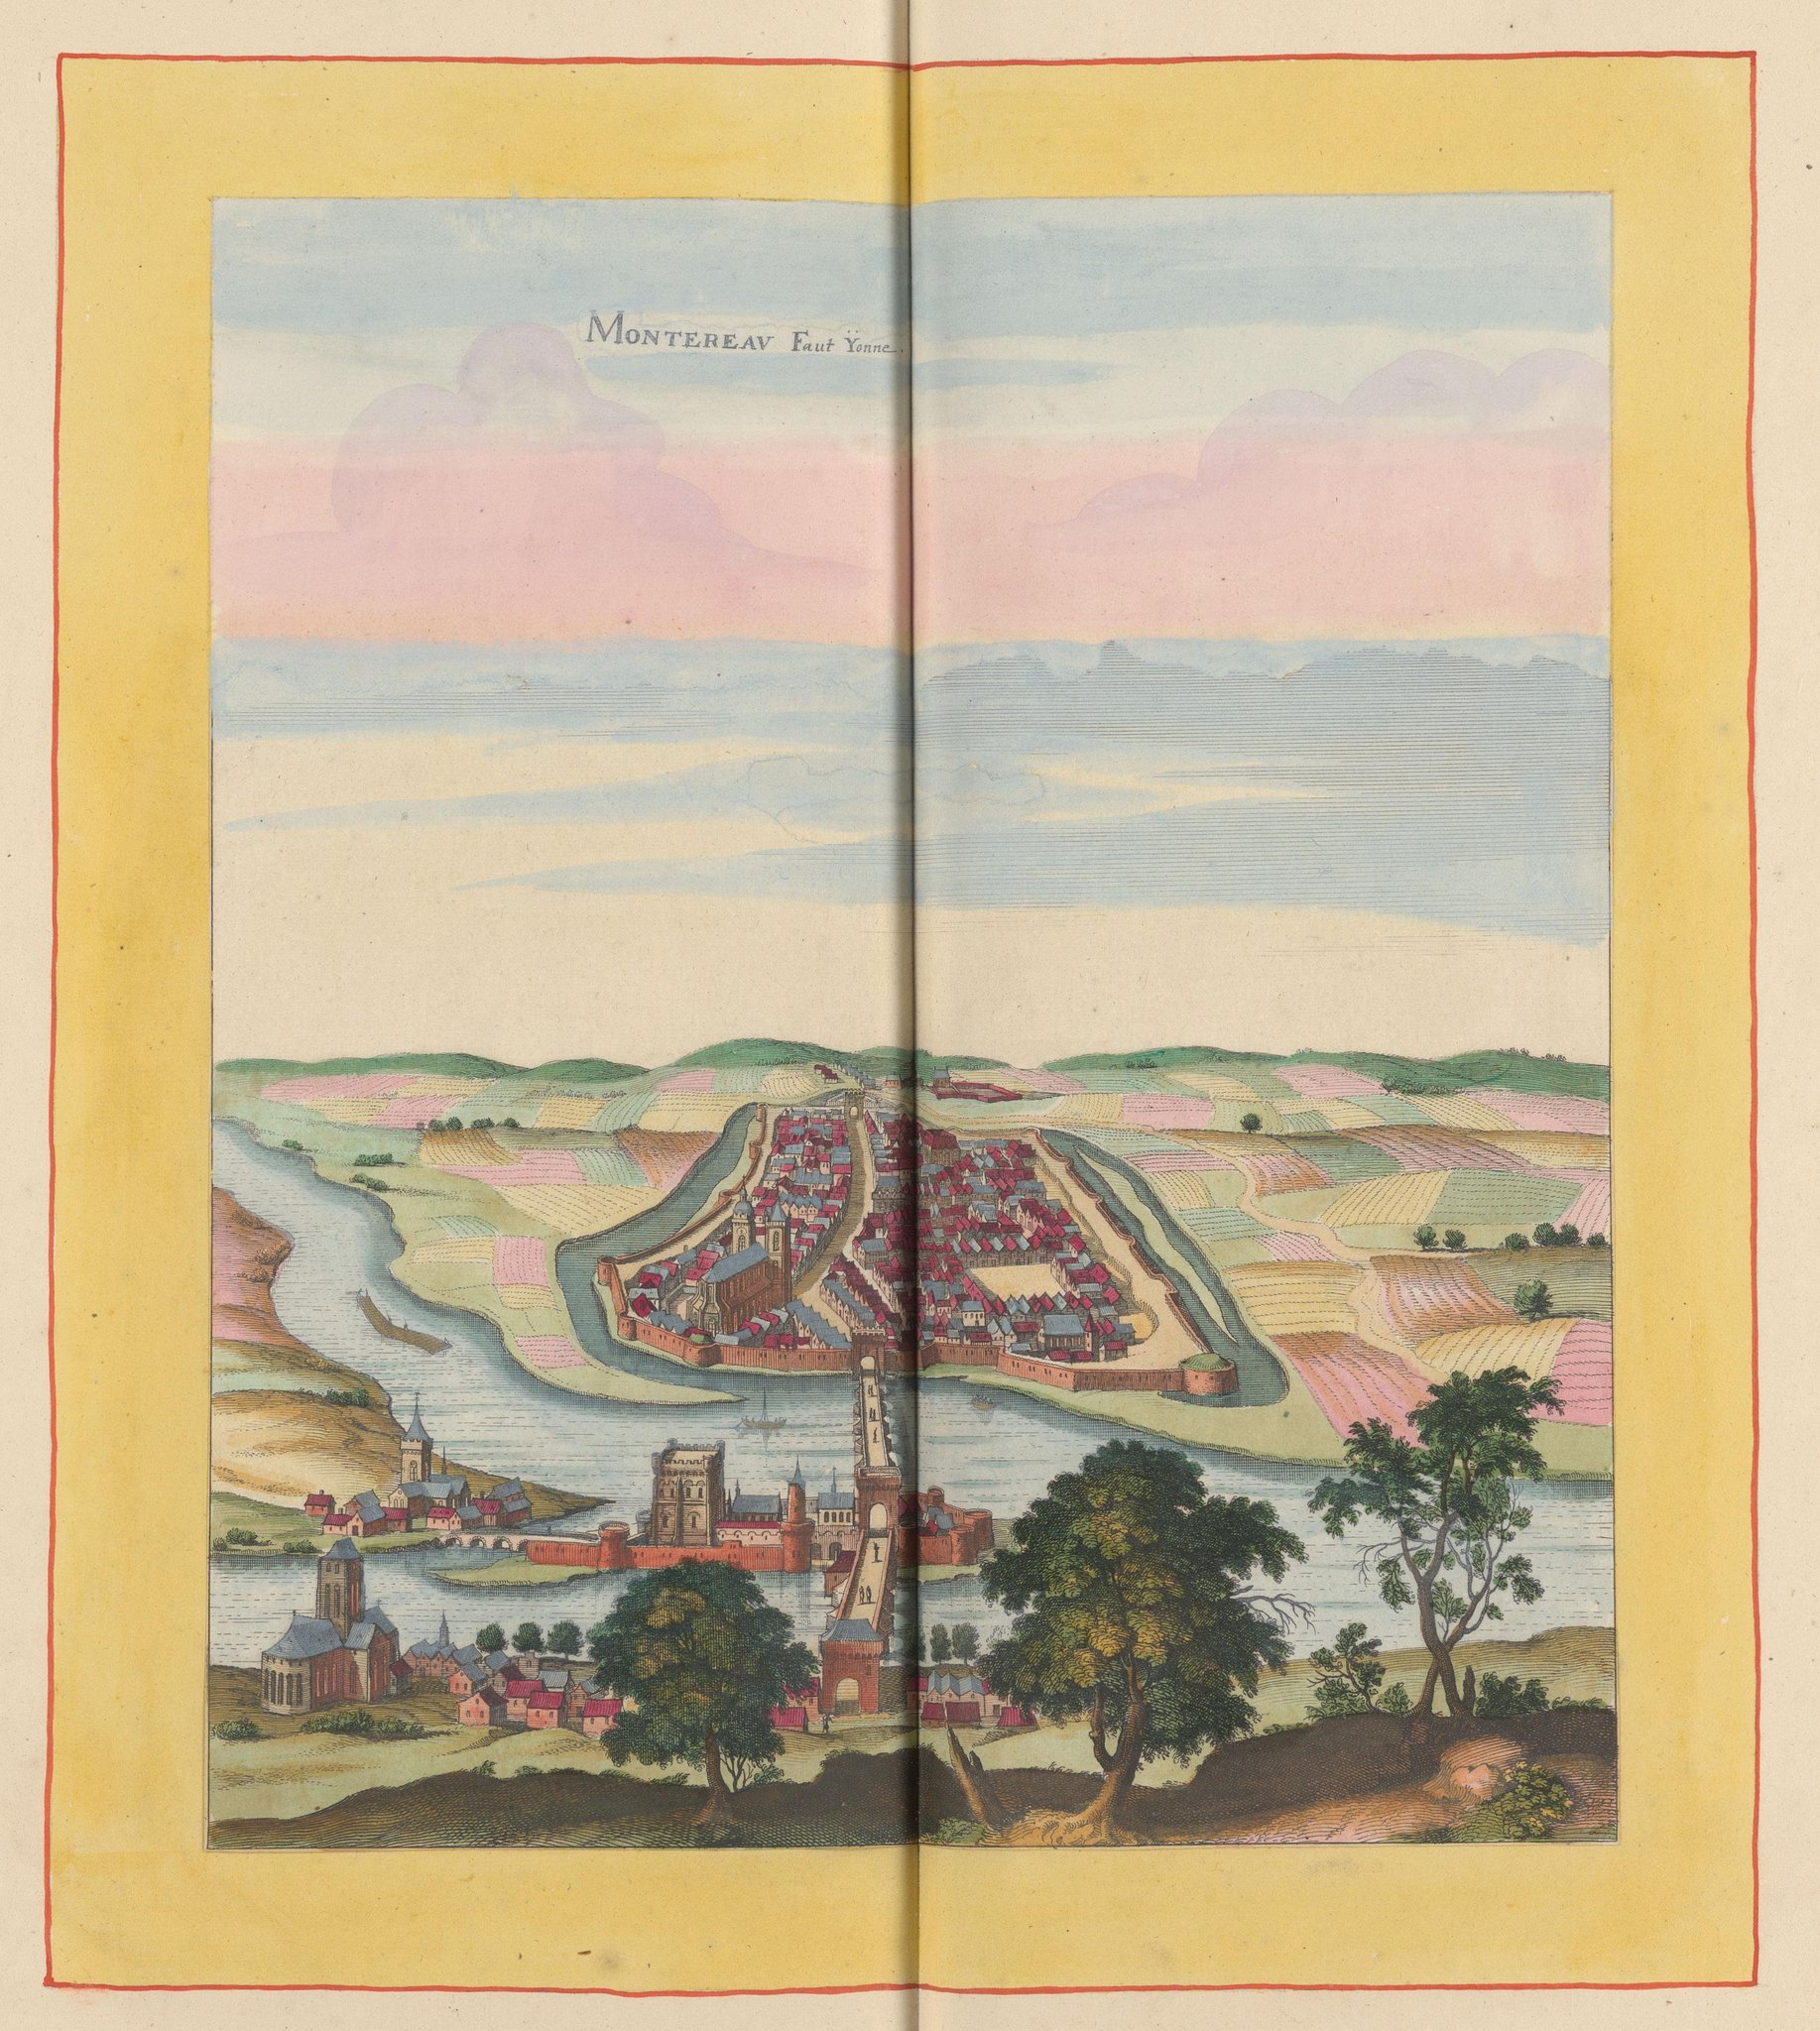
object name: print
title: Gezicht in vogelvluchtperspectief op Montereau-Fault-Yonne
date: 1656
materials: paper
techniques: engraving, etching, hand coloring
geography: the hague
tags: city-view in general; 'veduta'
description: Prent uit: Zeiller, Martin. Topographia Galliae. 13 dln. Frankfurt: Caspar Merian, 1656, dl. 3, na p. 22.